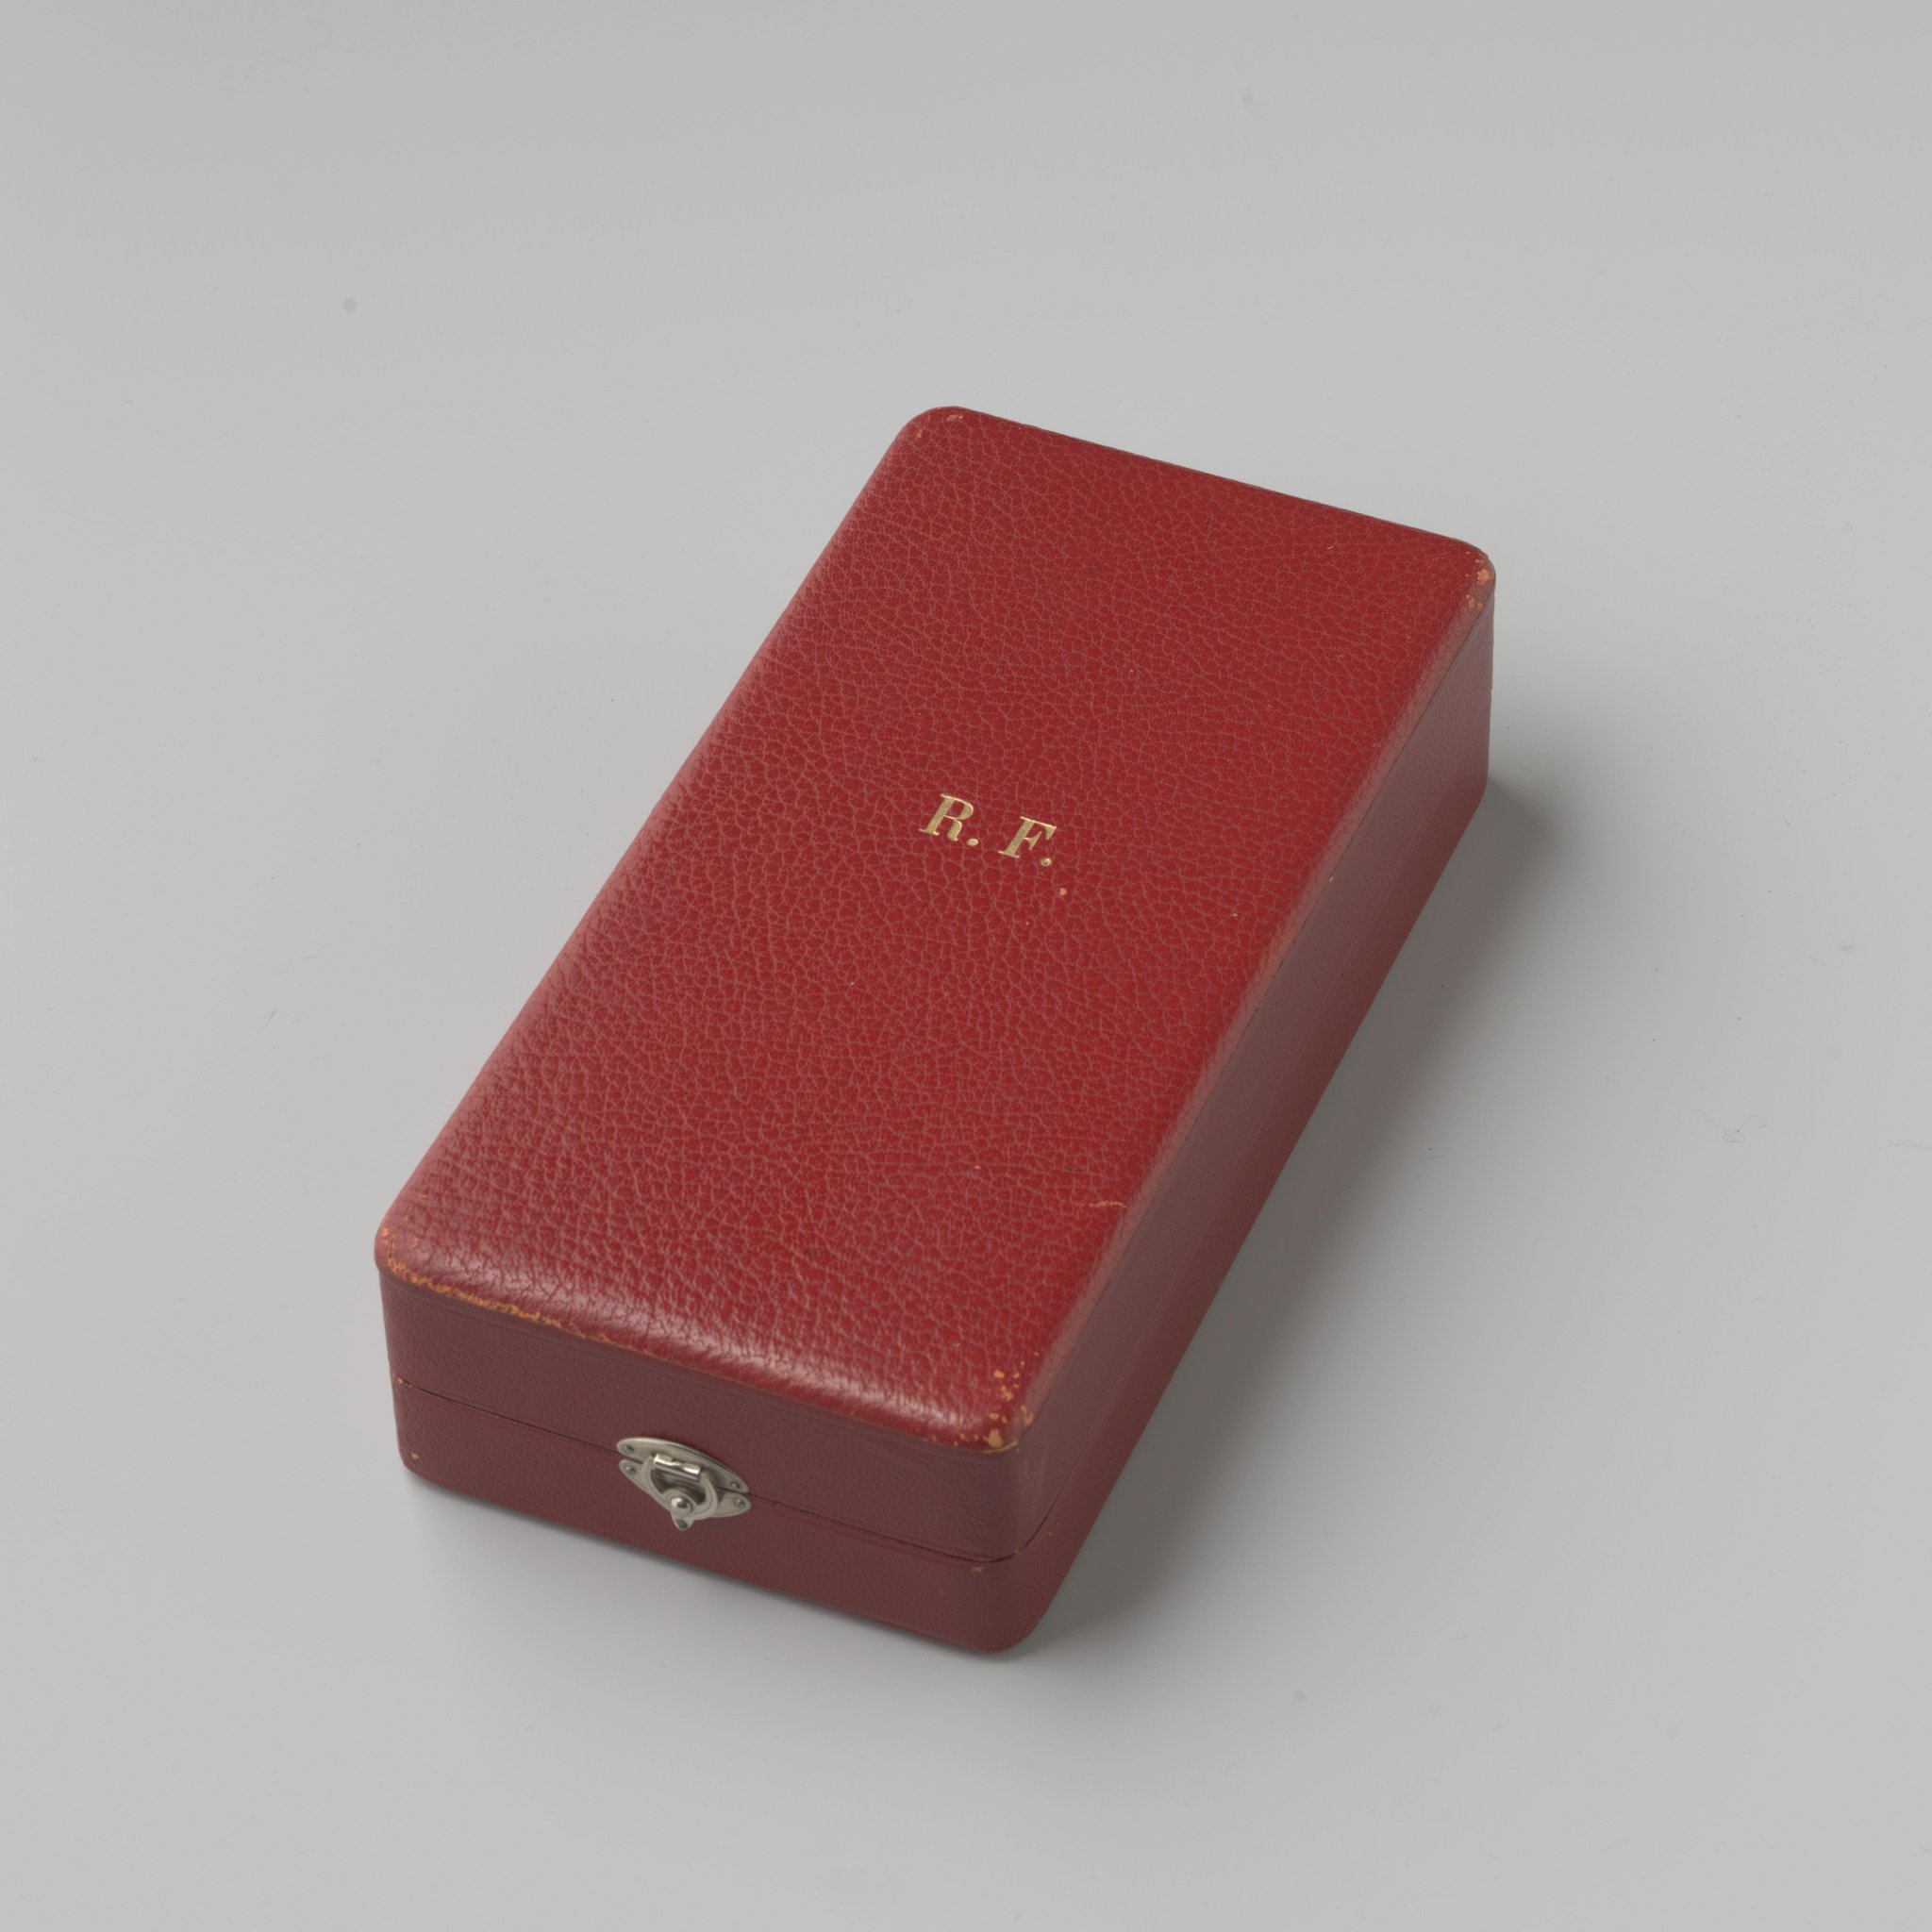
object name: box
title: Rood leren doos behorende bij de Franse ridderorde (Legion d'Honneur), ontvangen door Willem Drees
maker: arthus bertrand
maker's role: medailleur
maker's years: 1885-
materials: iron, leather, velvet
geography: paris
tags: amsterdam, the hague, willem drees, netherlands, france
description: Met rood leer beklede doos, de deksel is aan de binnenzijde met witte zijde gevoerd; de versierselen liggen op een beige fluwelen verhoging, waaronder de schouderband ligt. Los in de doos ligt een eenzijdig bedrukt vistiekaartje met de tekst 'RENE COTY / President de la Republique Francaise' met daaronder in handschrift 'avec ses compliments'.